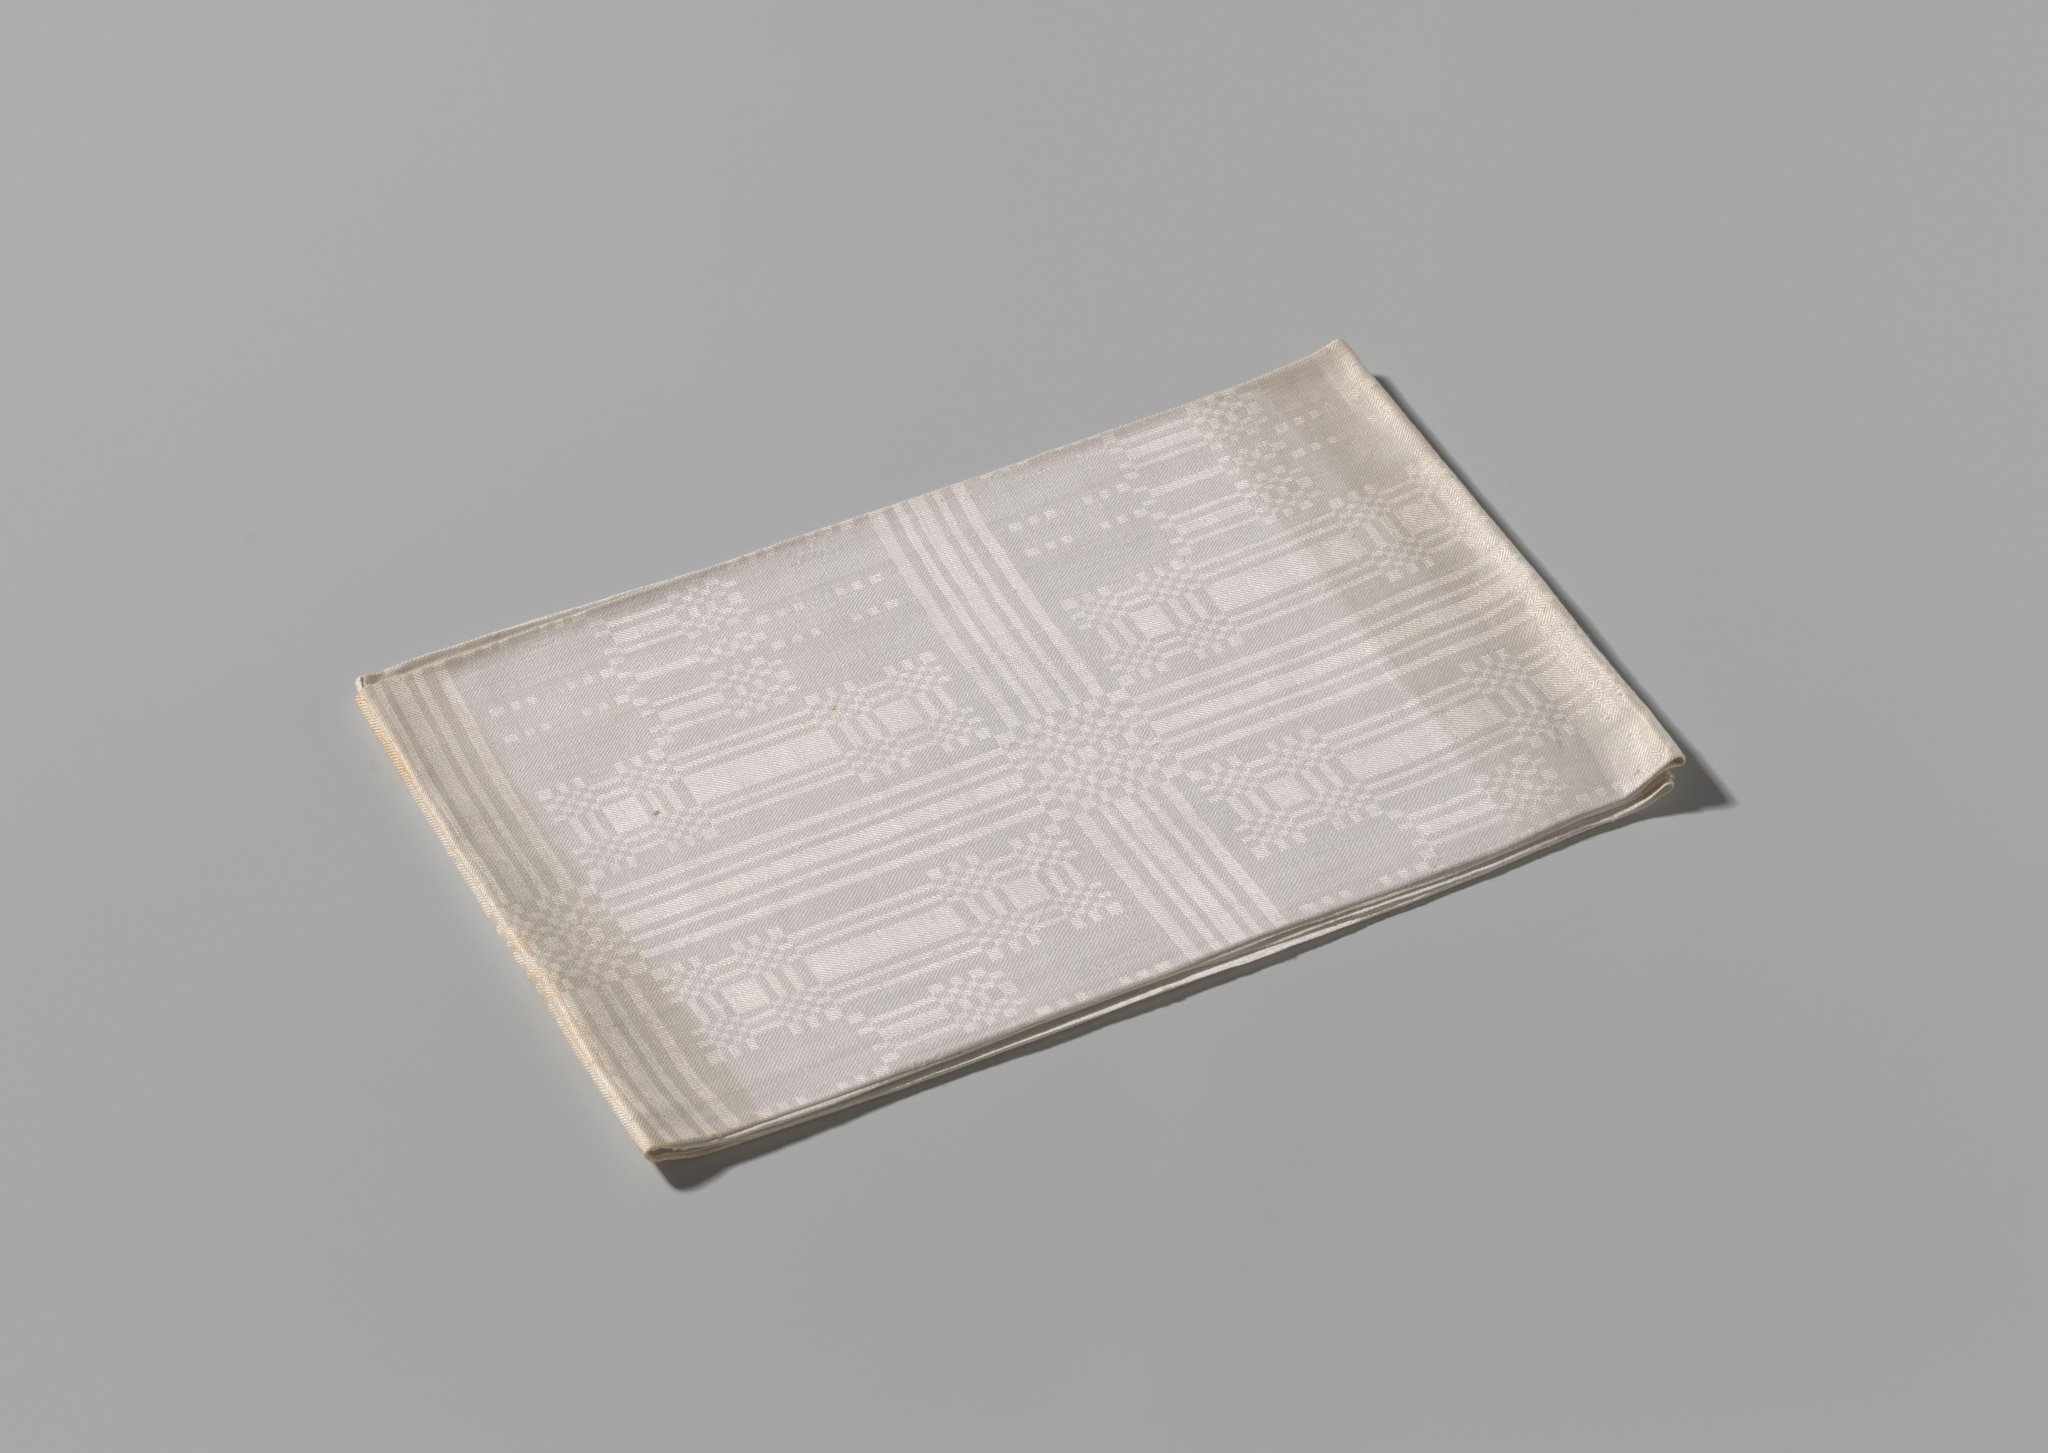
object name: handdwaal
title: Handdwaal van wit linnen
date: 1740-1786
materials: linen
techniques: twill, peeled fabric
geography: northern netherlands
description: Wit linnen handdwaal met pellen patroon, merk kroon IAVG 36.